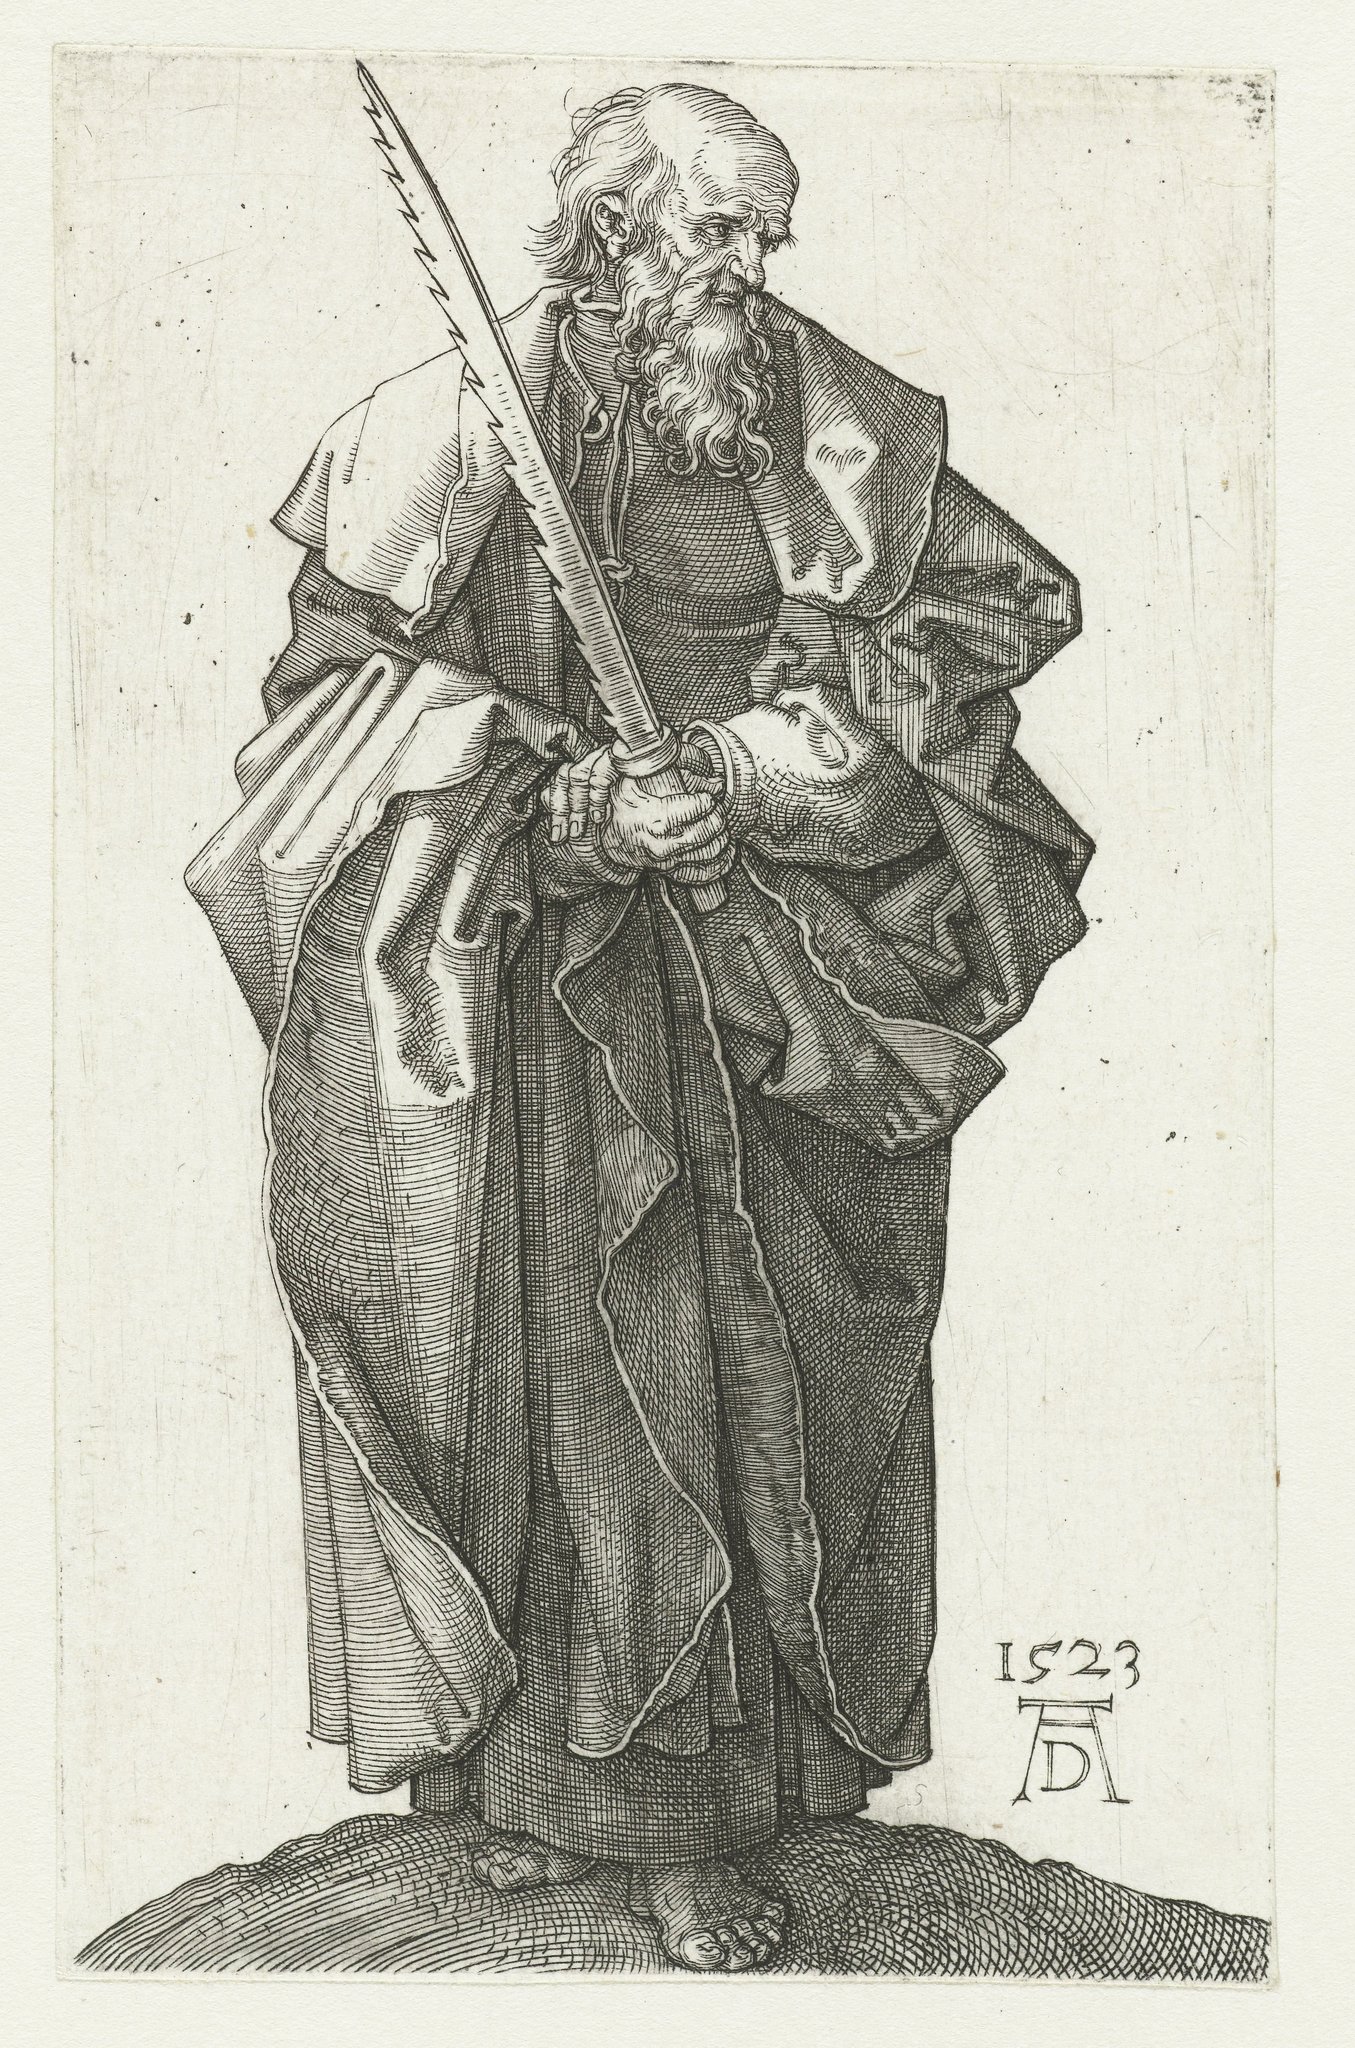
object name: print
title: De apostel Simon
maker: albrecht dürer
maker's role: draughtsman, painter, print maker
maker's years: 1471-1528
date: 1523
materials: paper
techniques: engraving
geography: nuremberg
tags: the apostle simon zelotes (or simon the canaanite); possible attributes: book, saw, scroll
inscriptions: collector's mark: Lugt 2228a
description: De apostel Simon, ten voeten uit, met een zaag in de hand. Deze prent is onderdeel van een (onvoltooide, want vijfdelige) serie van de twaalf apostelen.